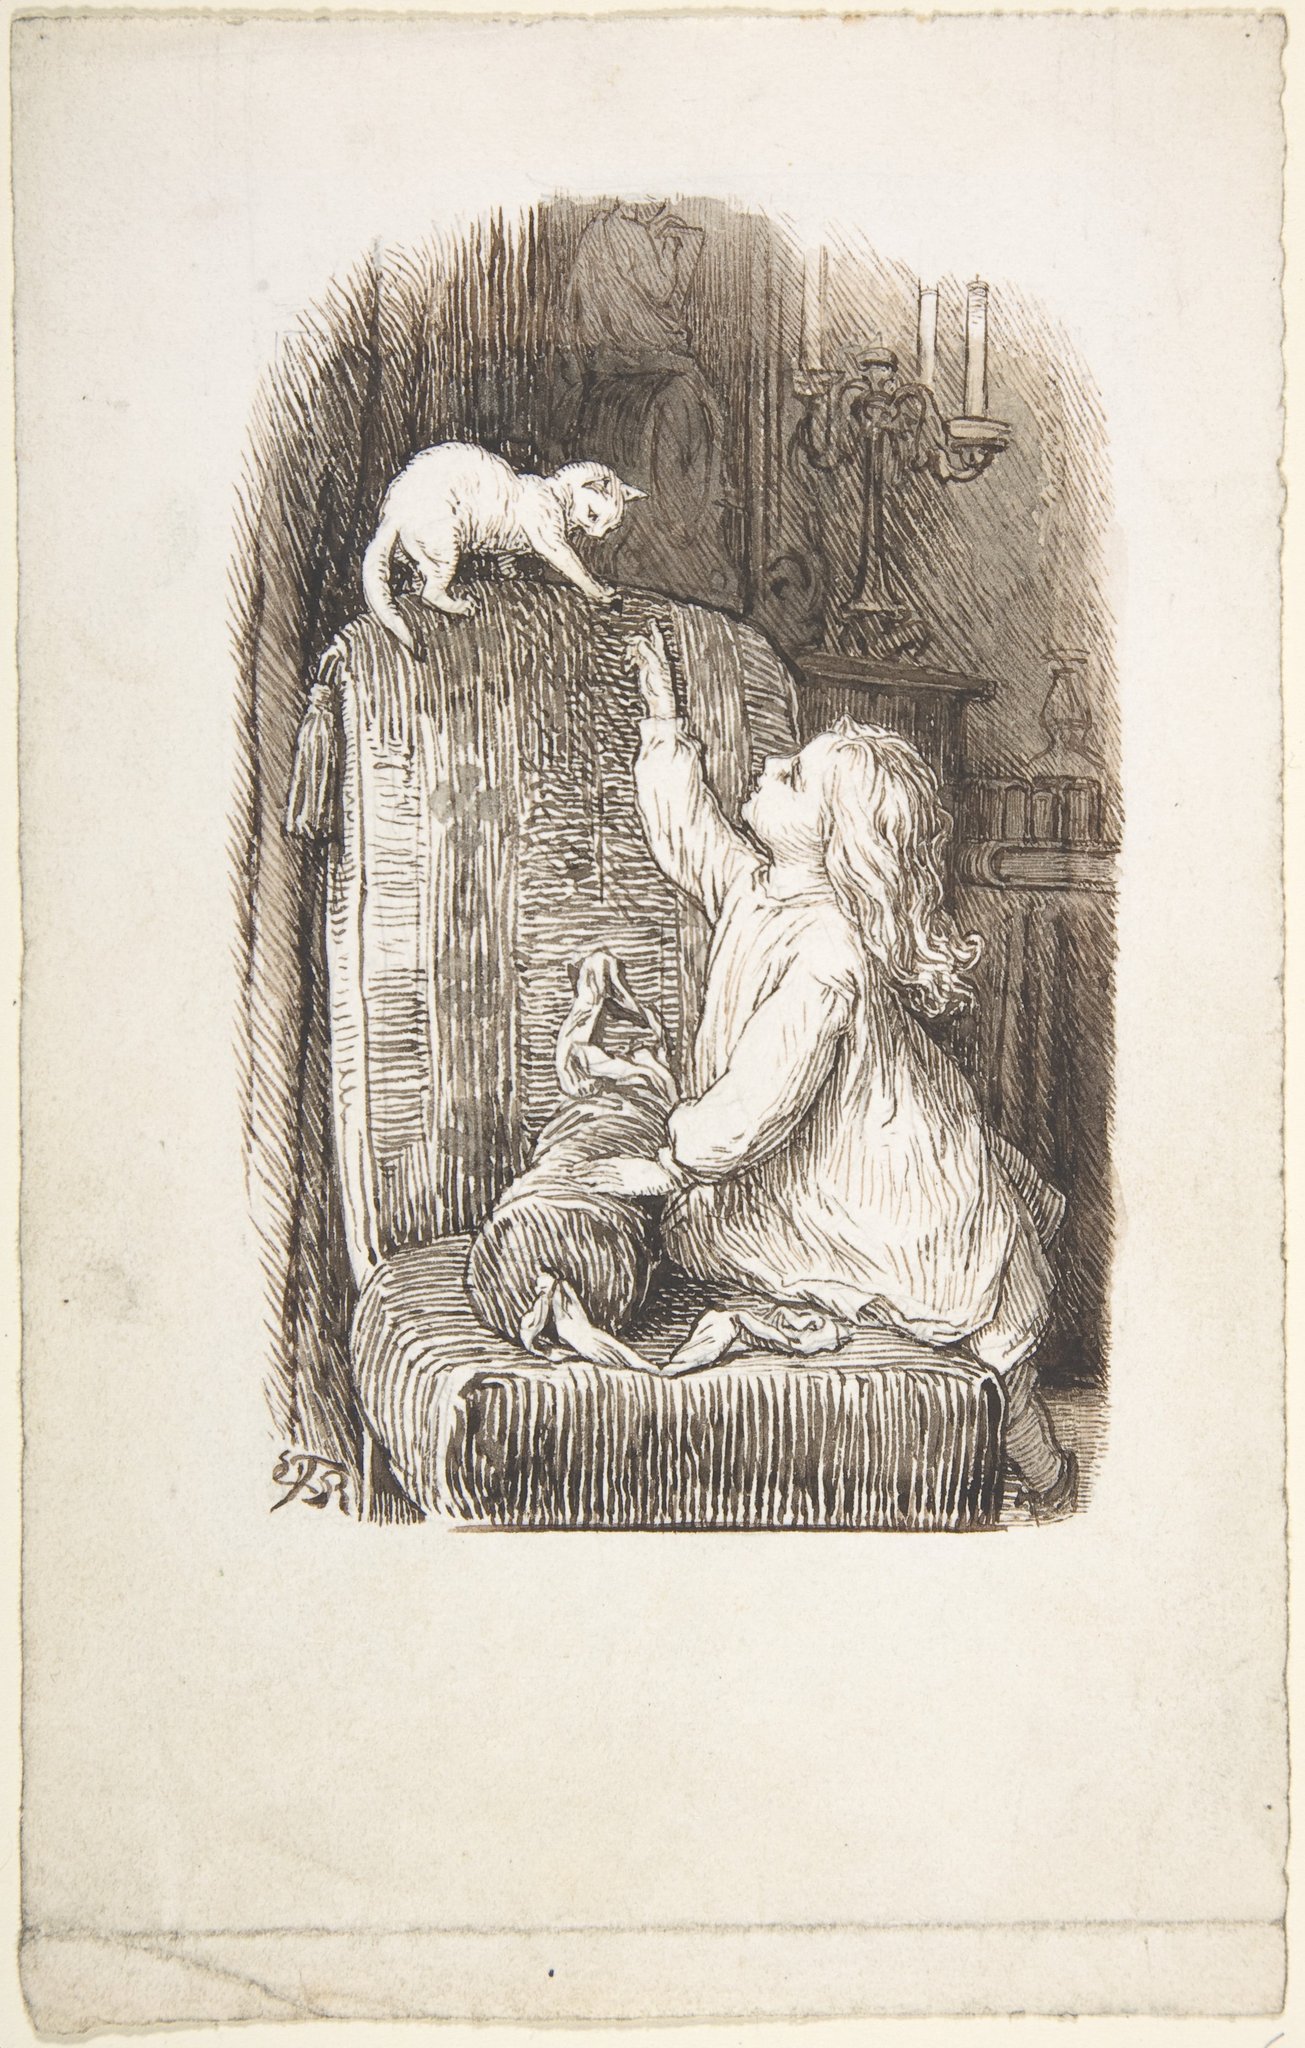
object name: drawing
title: Child Climbing a Chair to Reach for a Kitten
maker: lorenz frølich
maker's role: artist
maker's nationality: danish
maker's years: 1820-1908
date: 1835-1903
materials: graphite, ink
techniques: brush, pen, wash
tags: girls,cats,chairs